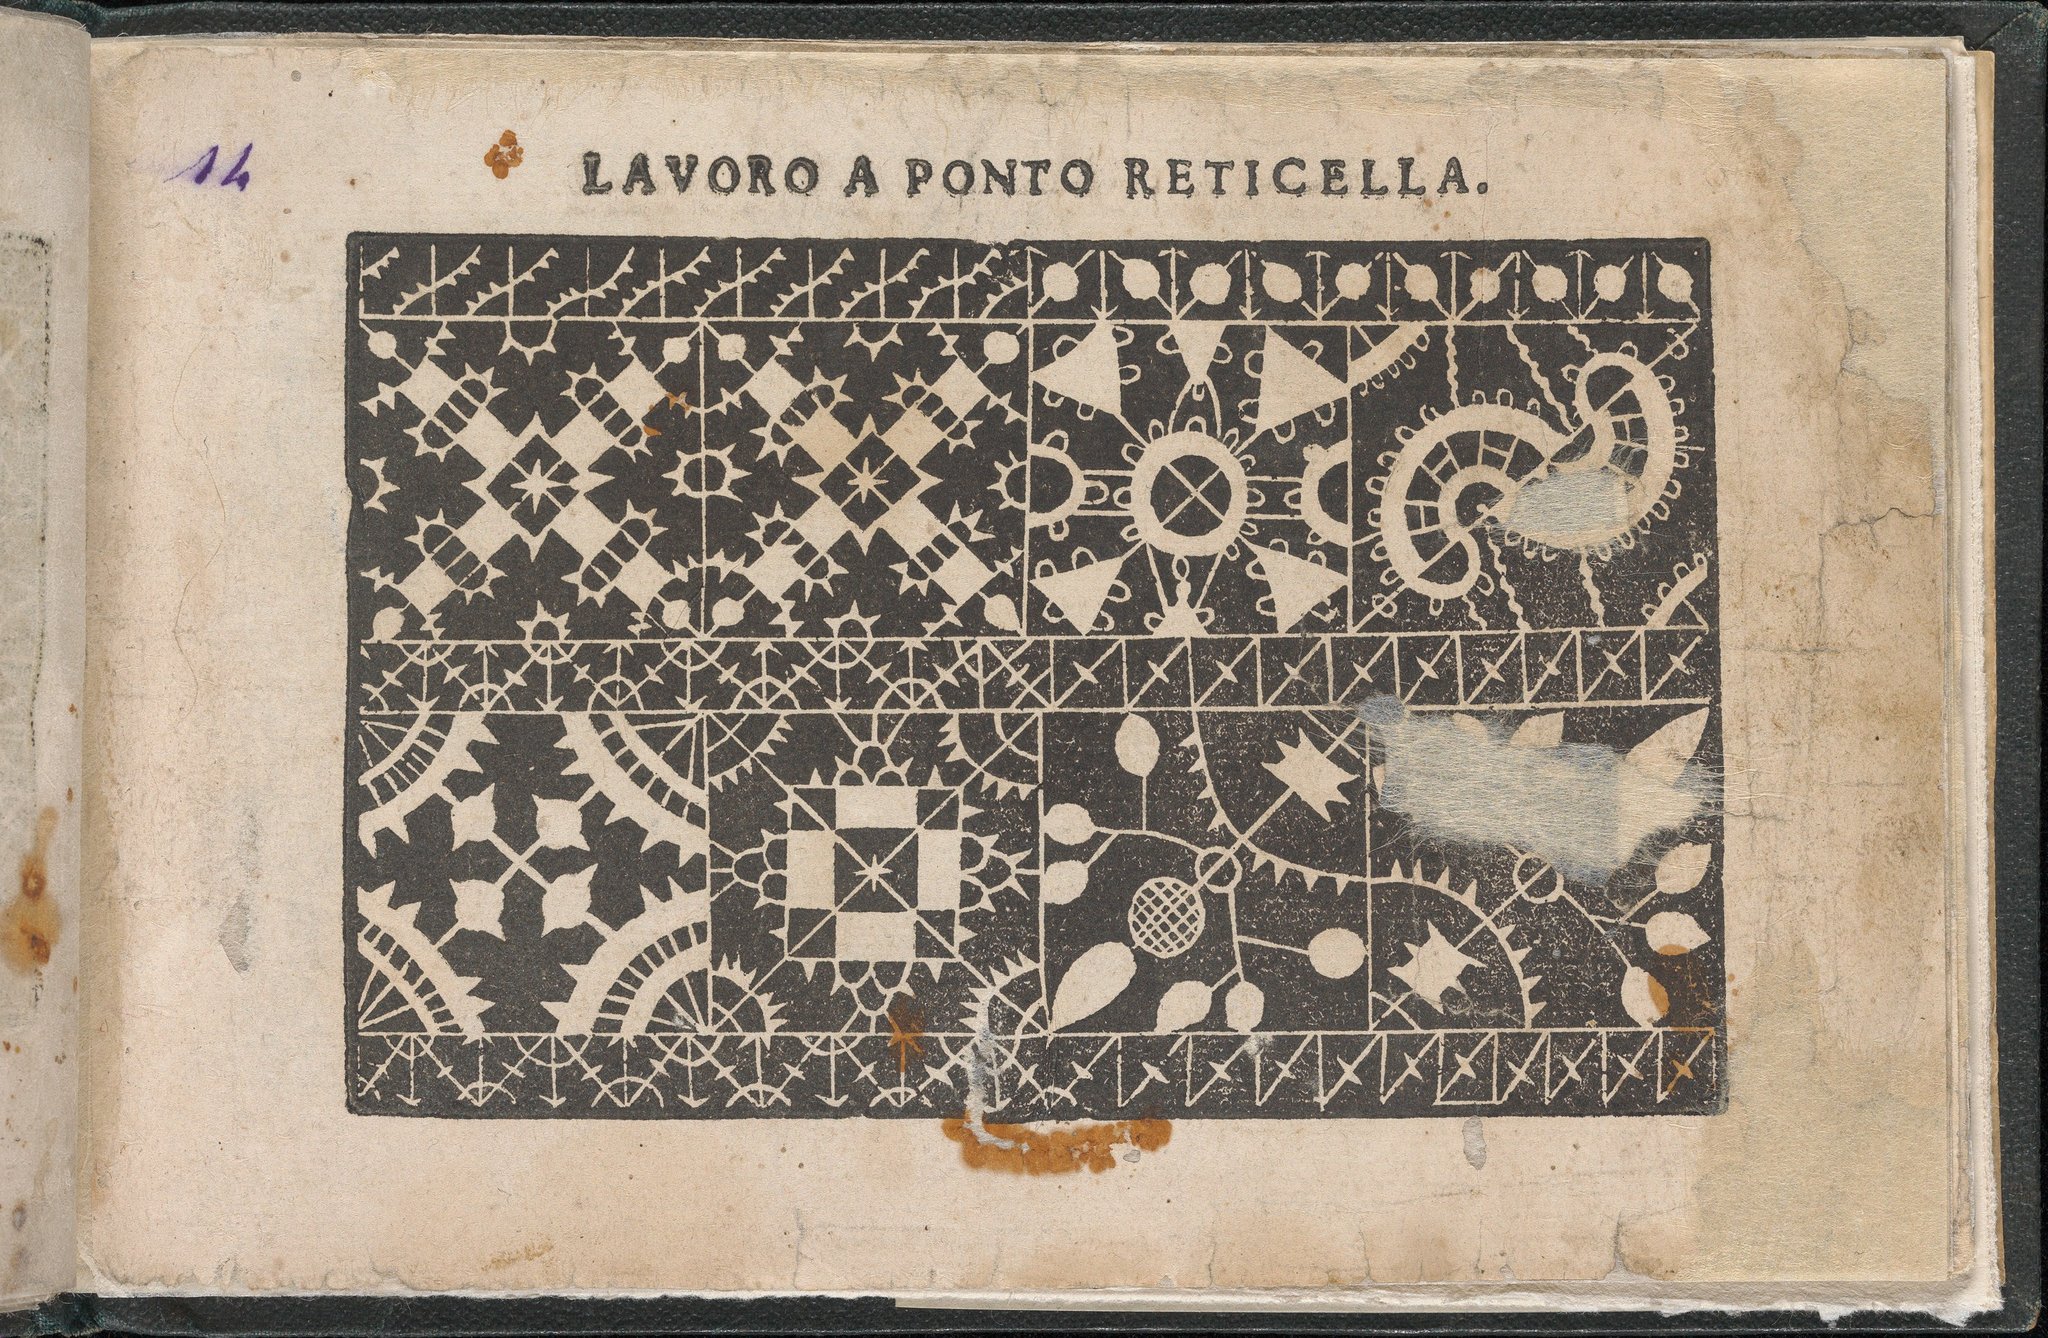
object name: book print ornament architecture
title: Gemma pretiosa della virtuose donne, page 14 (recto)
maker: isabella catanea parasole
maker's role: designer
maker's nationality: italian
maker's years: 1565-1625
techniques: woodcut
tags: ornament